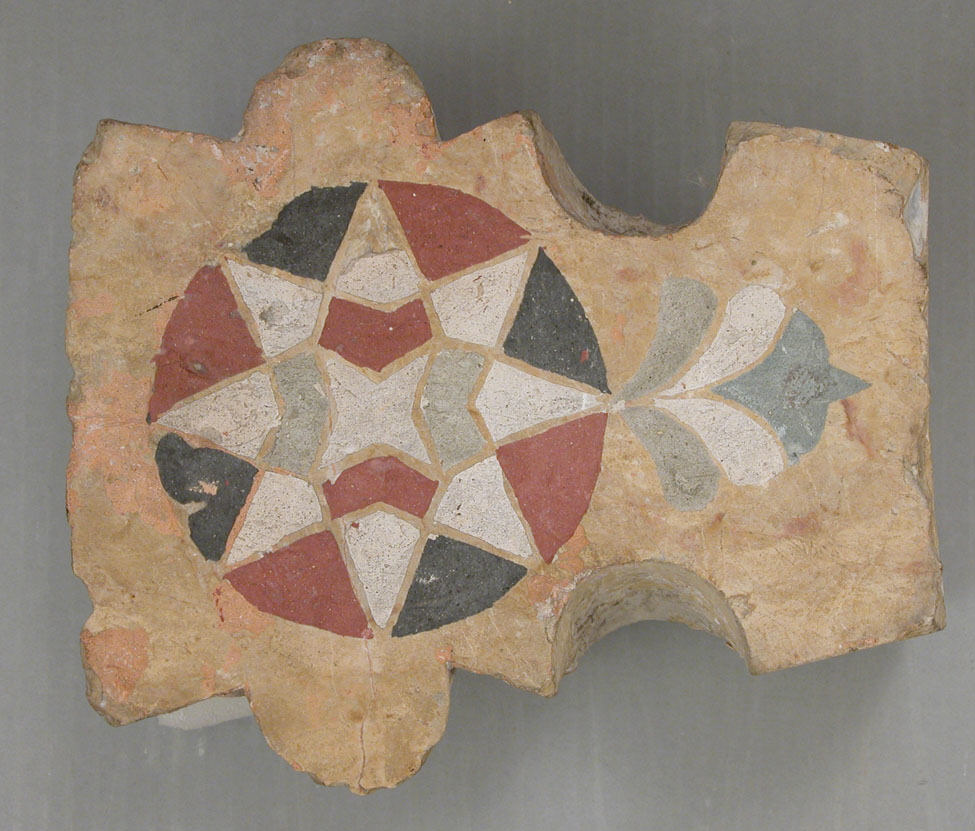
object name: tile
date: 1101-1400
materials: earthenware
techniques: glazing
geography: egypt